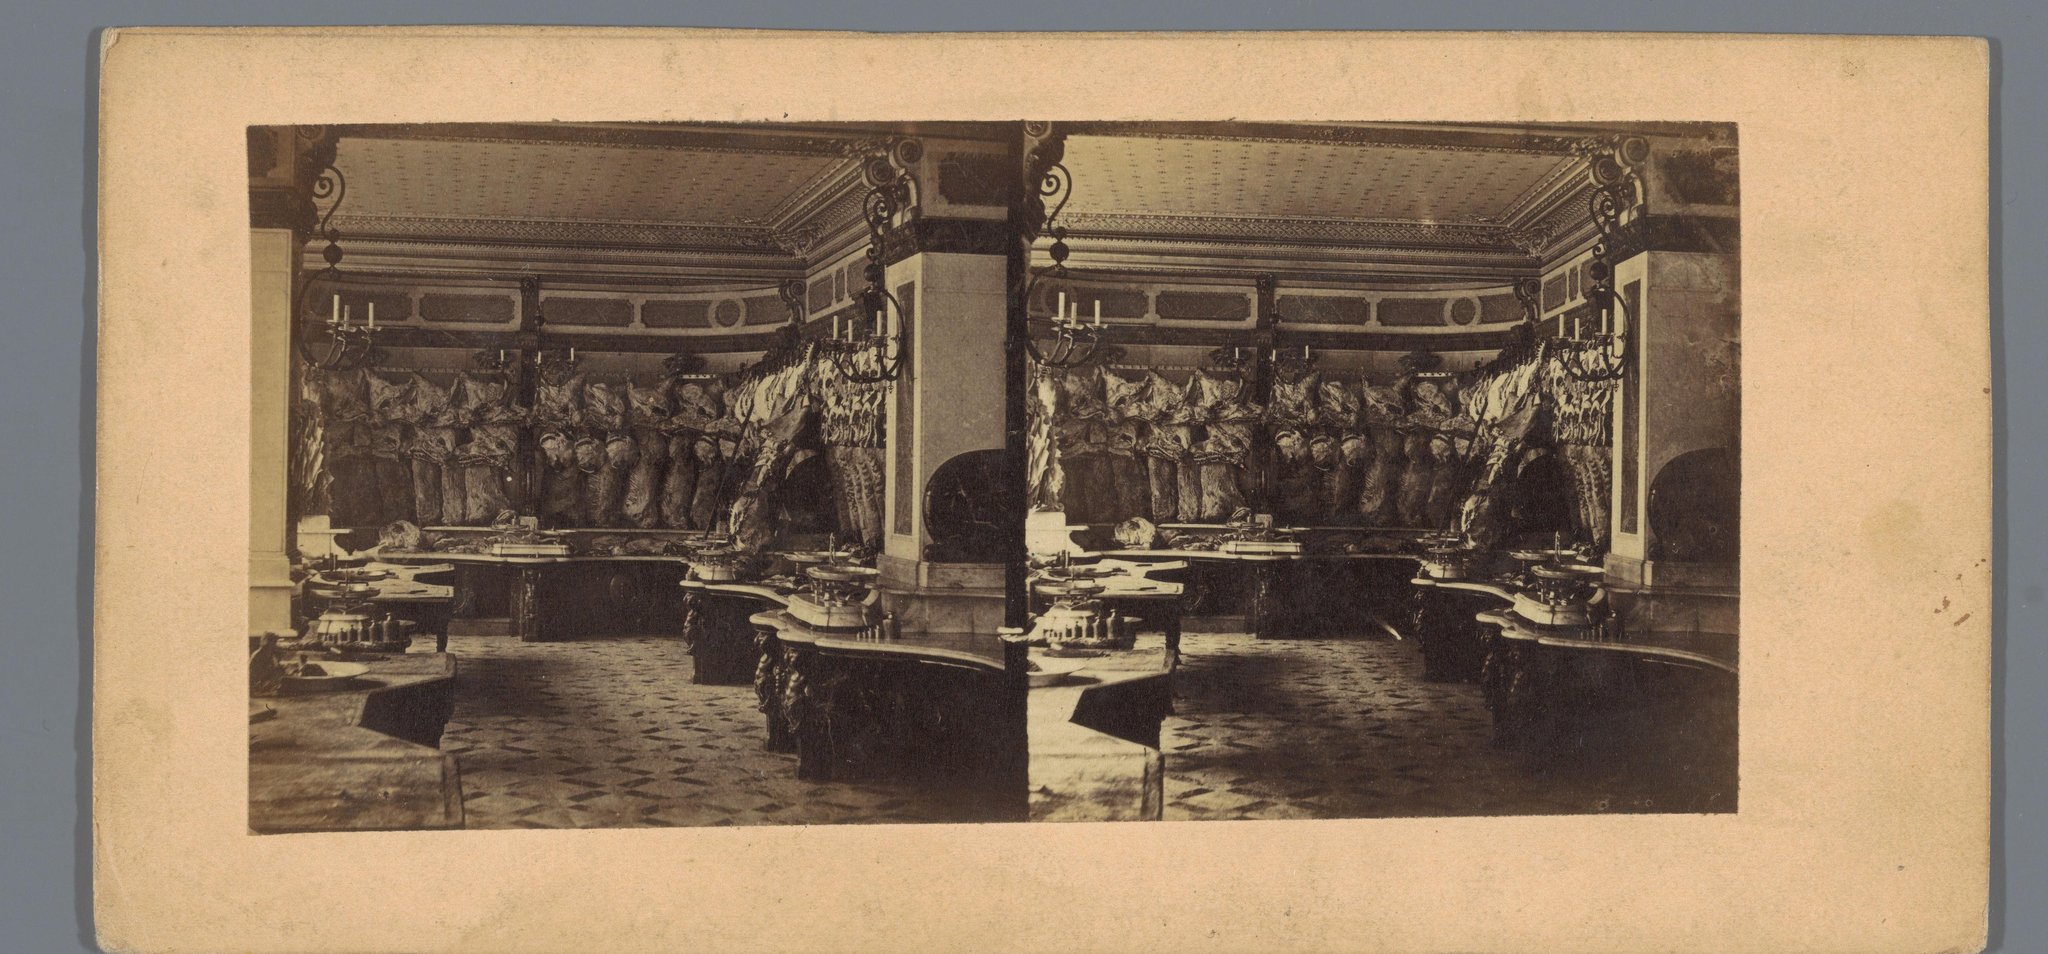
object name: stereograph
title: Boucherie Duval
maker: Anonymous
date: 1855-1860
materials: cardboard, photographic support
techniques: albumen print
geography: paris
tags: butcher, slaughterman, paris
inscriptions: number: ‘No. 31’, inscription: ‘Boucherie duval’